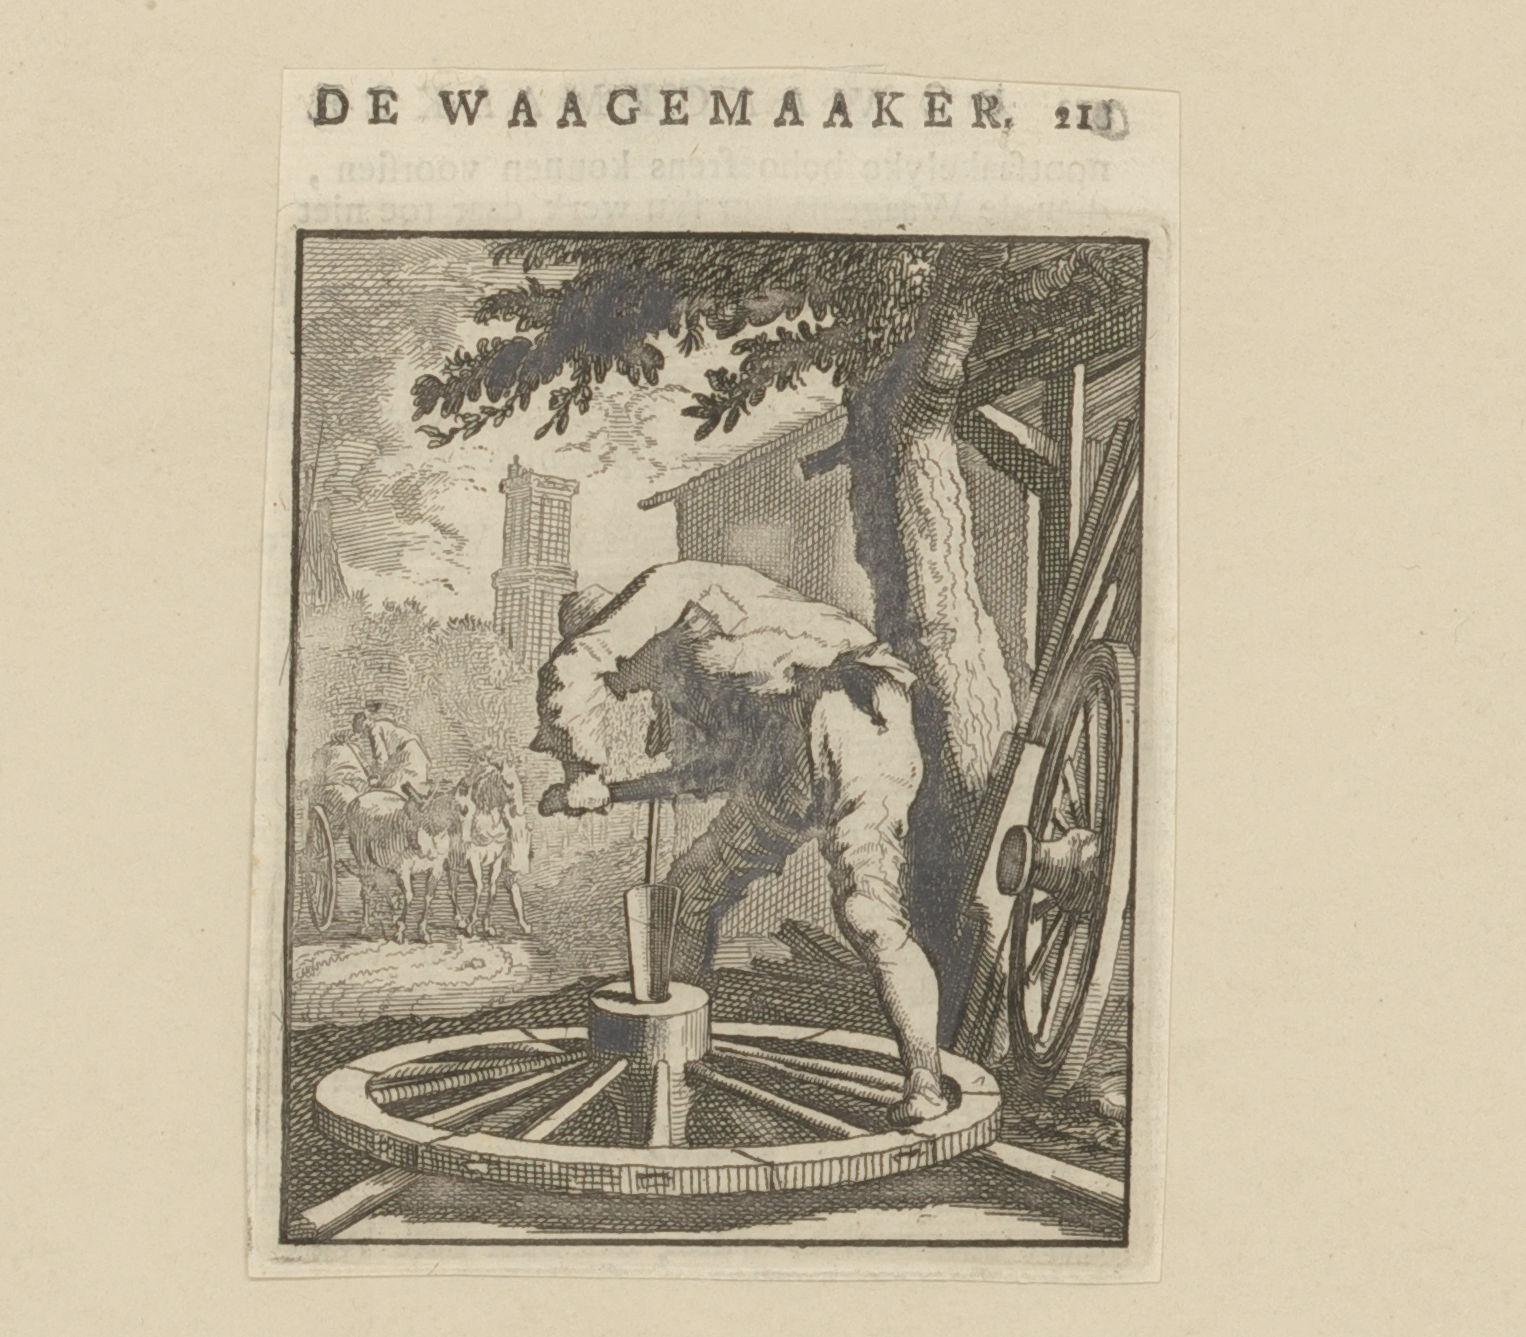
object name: print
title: Man maakt een wiel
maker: Anonymous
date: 1719-1759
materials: paper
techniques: etching, letterpress printing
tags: wheel (of vehicle), handicrafts, craftsman at work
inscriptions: collector's mark: Lugt 1641, stamp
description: Prent met andere letterzetting gebruikt in: St. Clara, Abraham van. Iets voor allen. [Vertaald door] J. le Long. Amsterdam: Janssoons van Waesberge, 1719, dl. 2. En in: St. Clara, Abraham van. Iets voor allen. [Vertaald door] J. le Long. Amsterdam: Jan Roman de Jonge, 1741, dl. 2. En in: St. Clara, Abraham van. Iets voor allen. [Vertaald door] J. le Long. Amsterdam: Jan Roman, 1759, dl. 2. Huidige prent uit een andere editie. Naar een prent van: Jan Luyken.